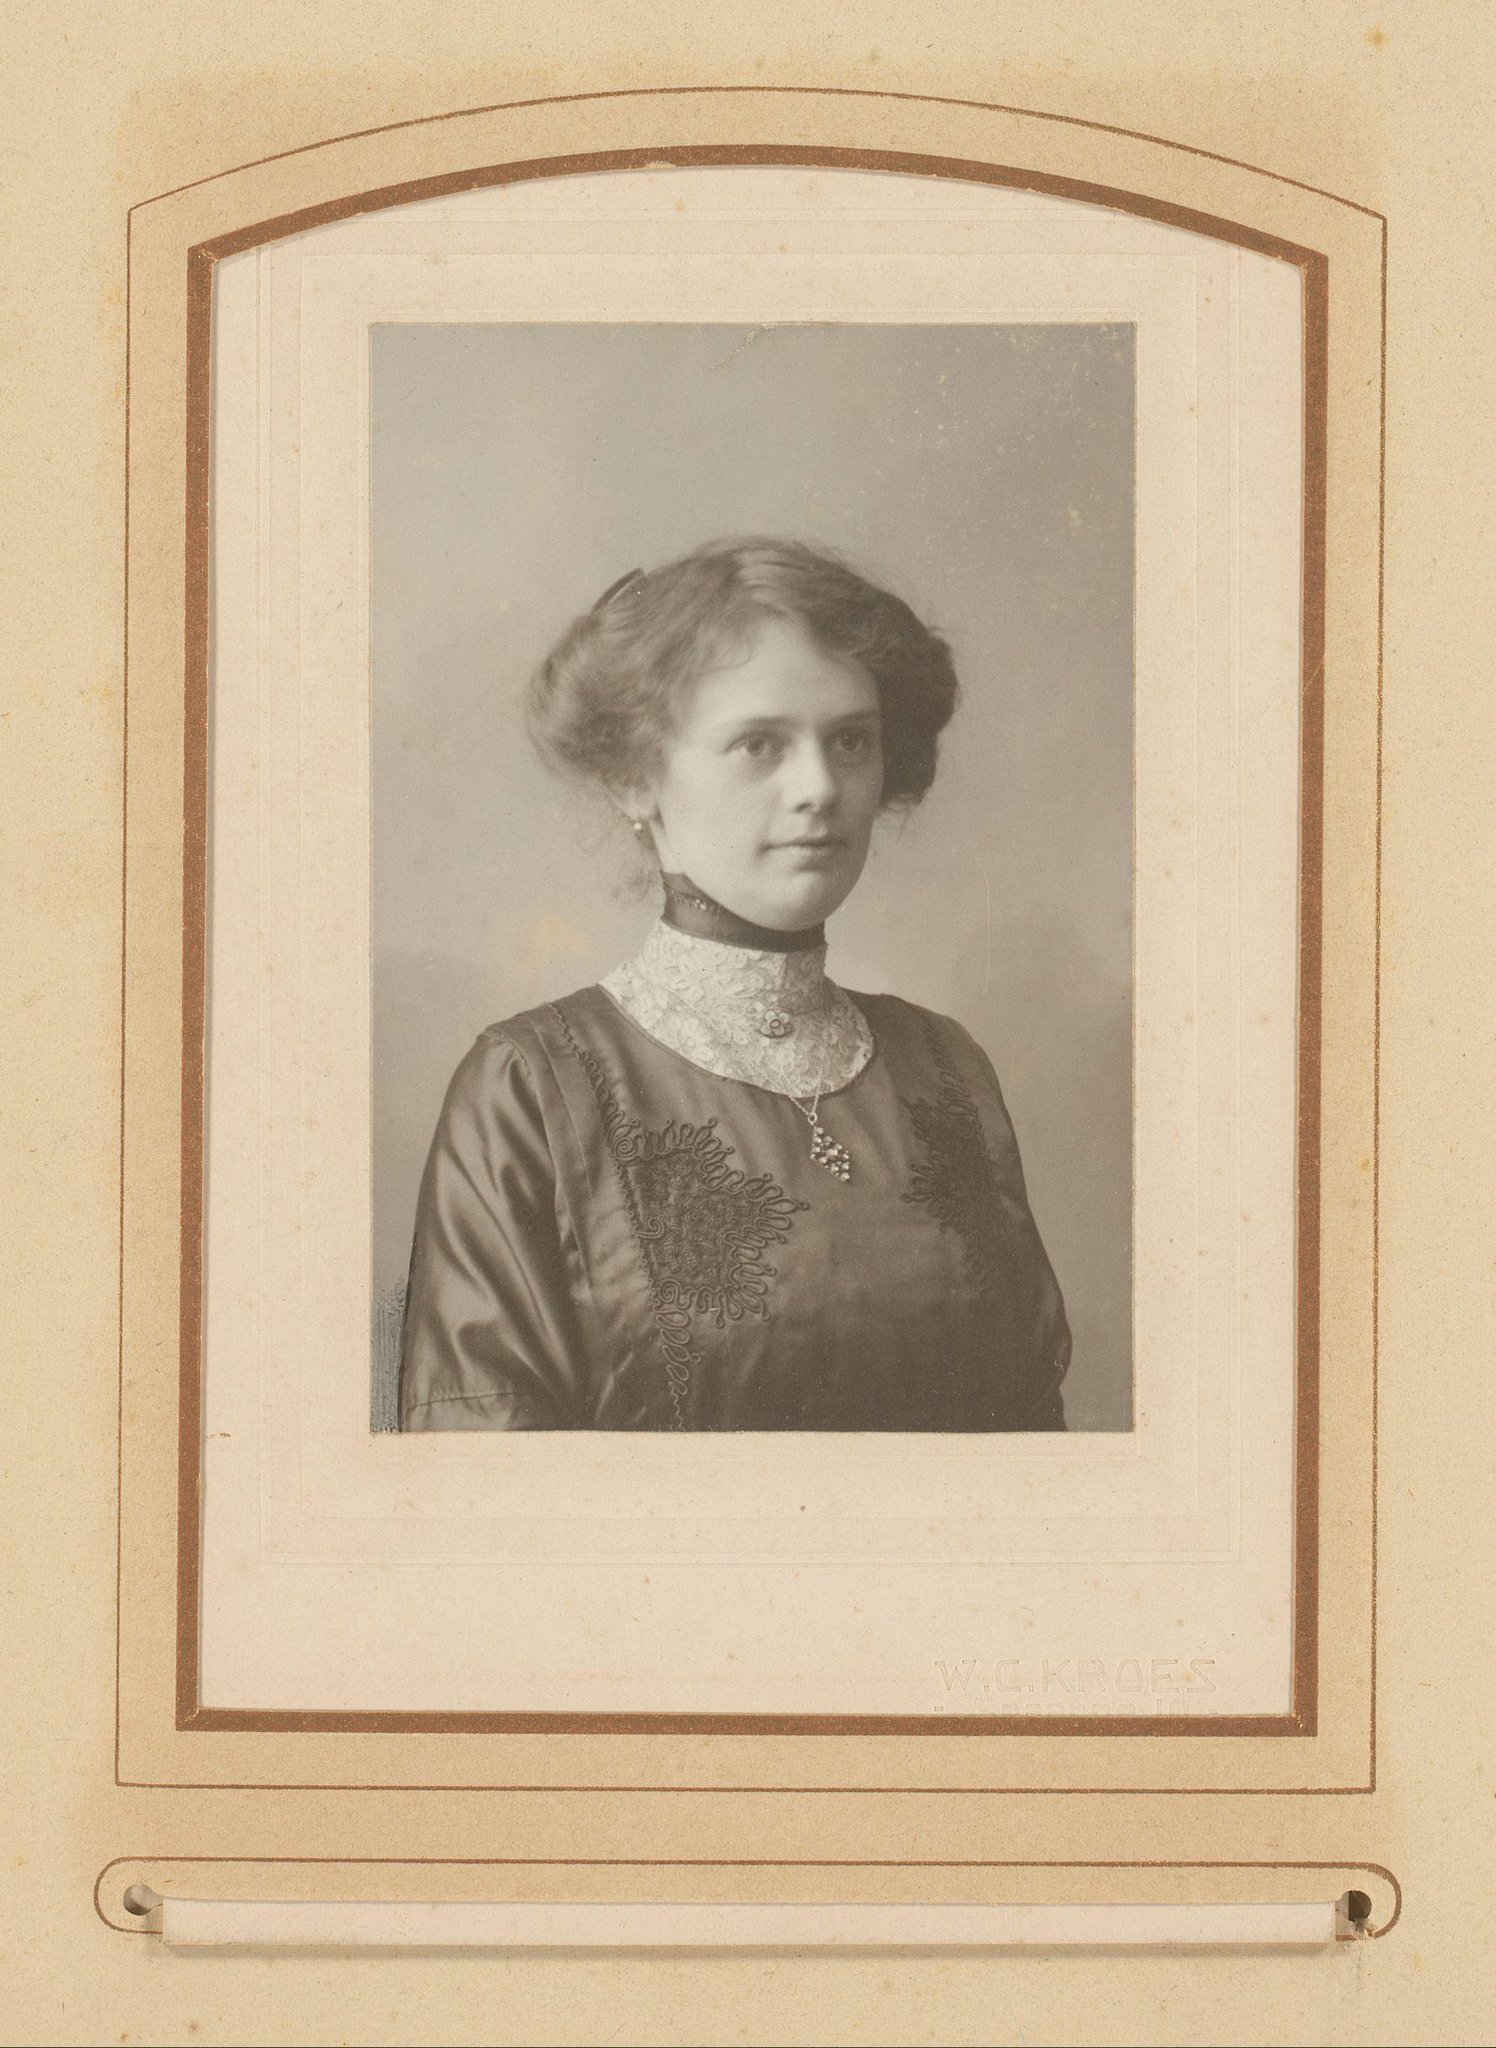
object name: album leaf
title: Portret van een vrouw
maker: willem christiaan kroes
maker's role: draughtsman, painter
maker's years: 1868-1954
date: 1908-1920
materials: cardboard, photographic support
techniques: collodion silver print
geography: haarlem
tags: historical persons - bb - woman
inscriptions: inscription: ‘W.C. Kroes/ Spaarne, 10/ Haarlem’